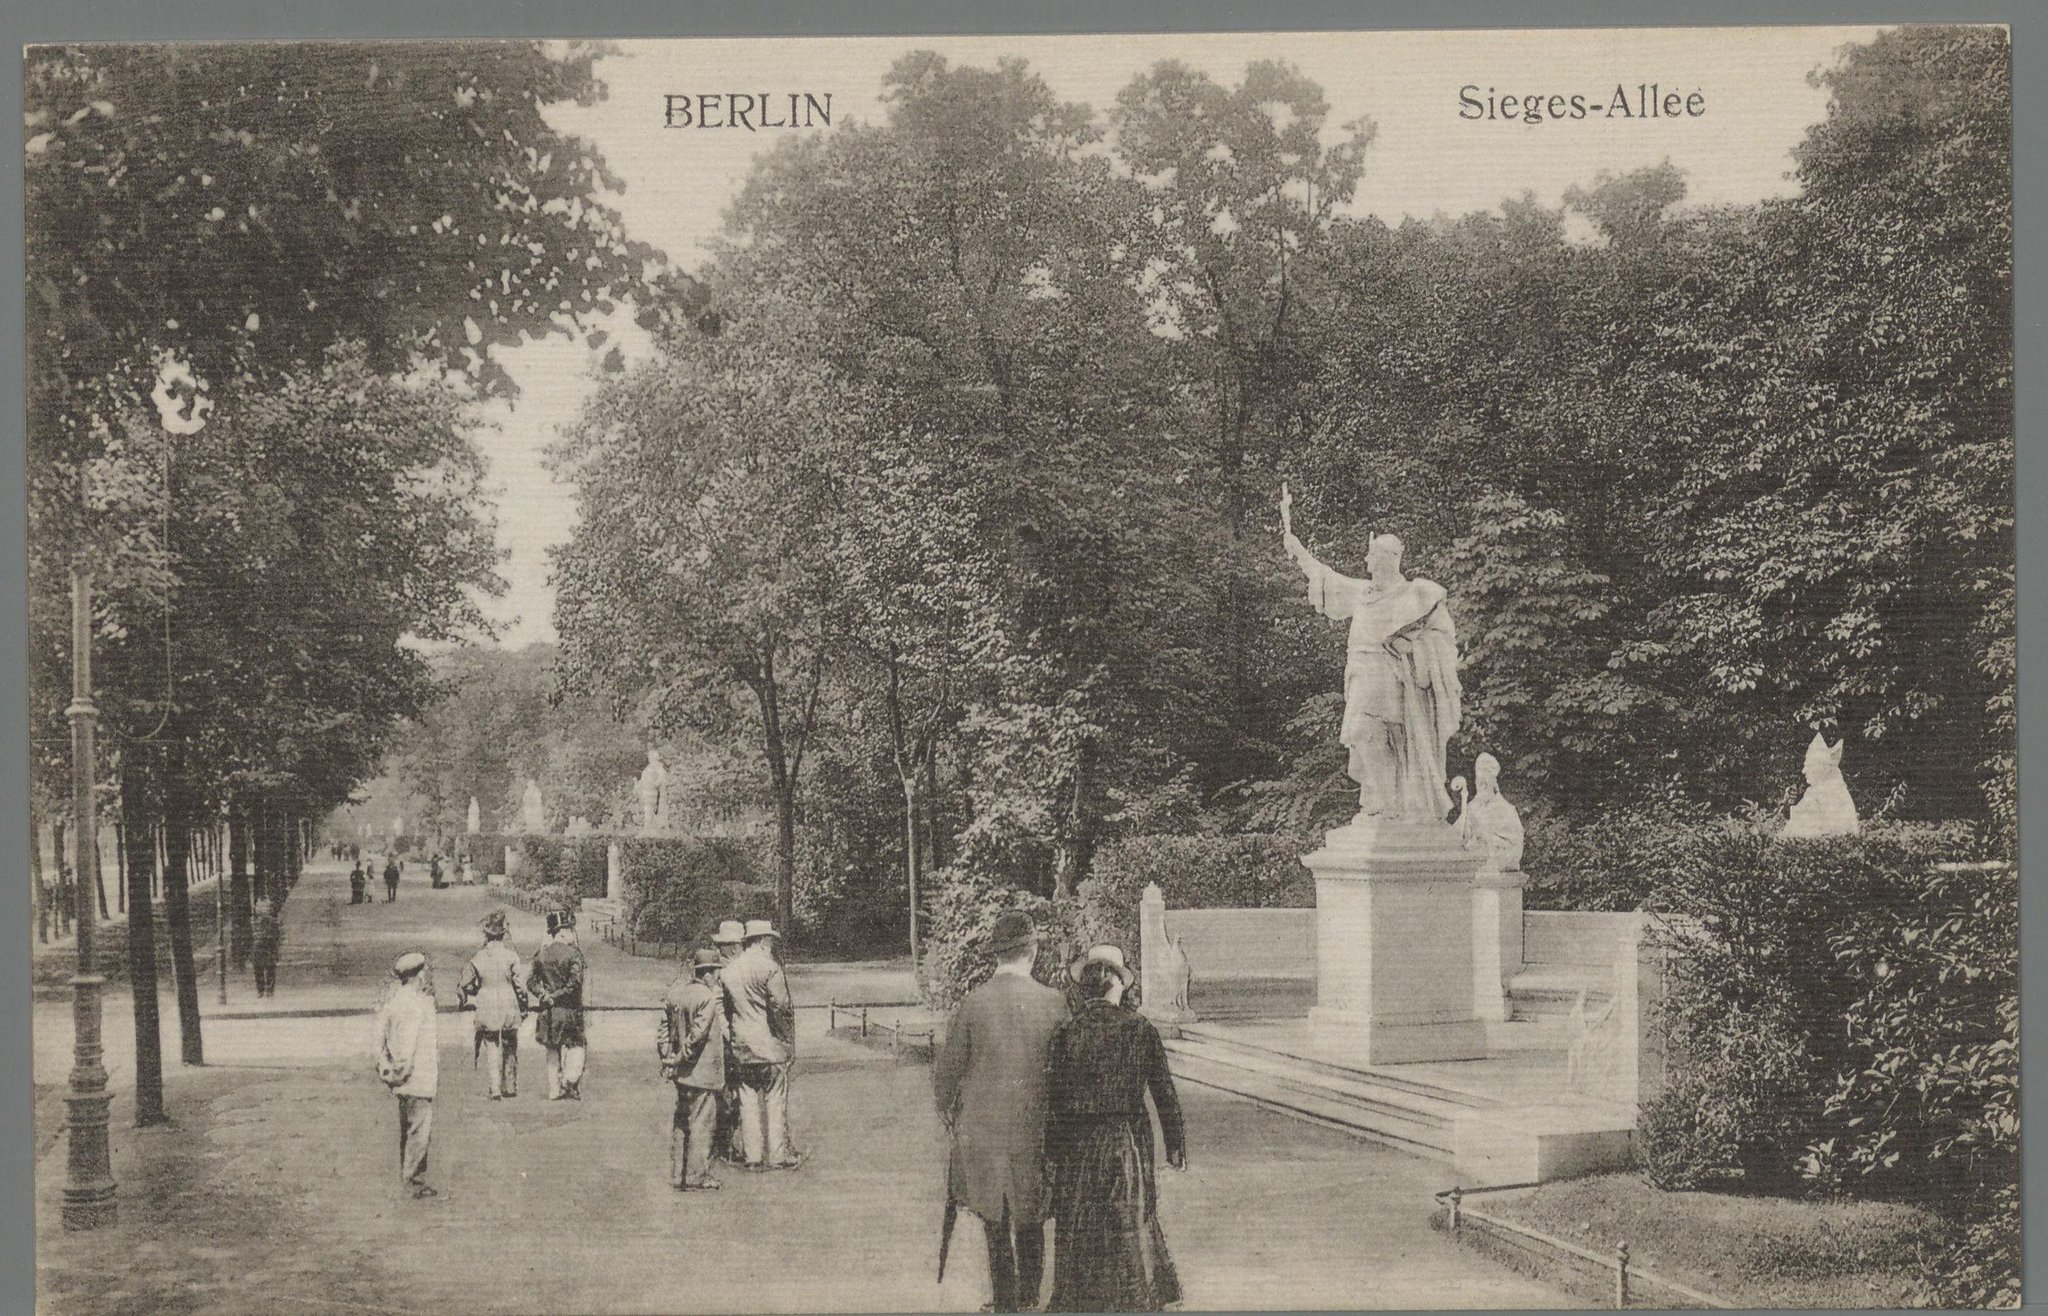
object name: photomechanical print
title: Berlin. Sieges-Allee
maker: Anonymous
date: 1905-1930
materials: cardboard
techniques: photograph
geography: berlin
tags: avenue, boulevard in village, monument, statue, berlin